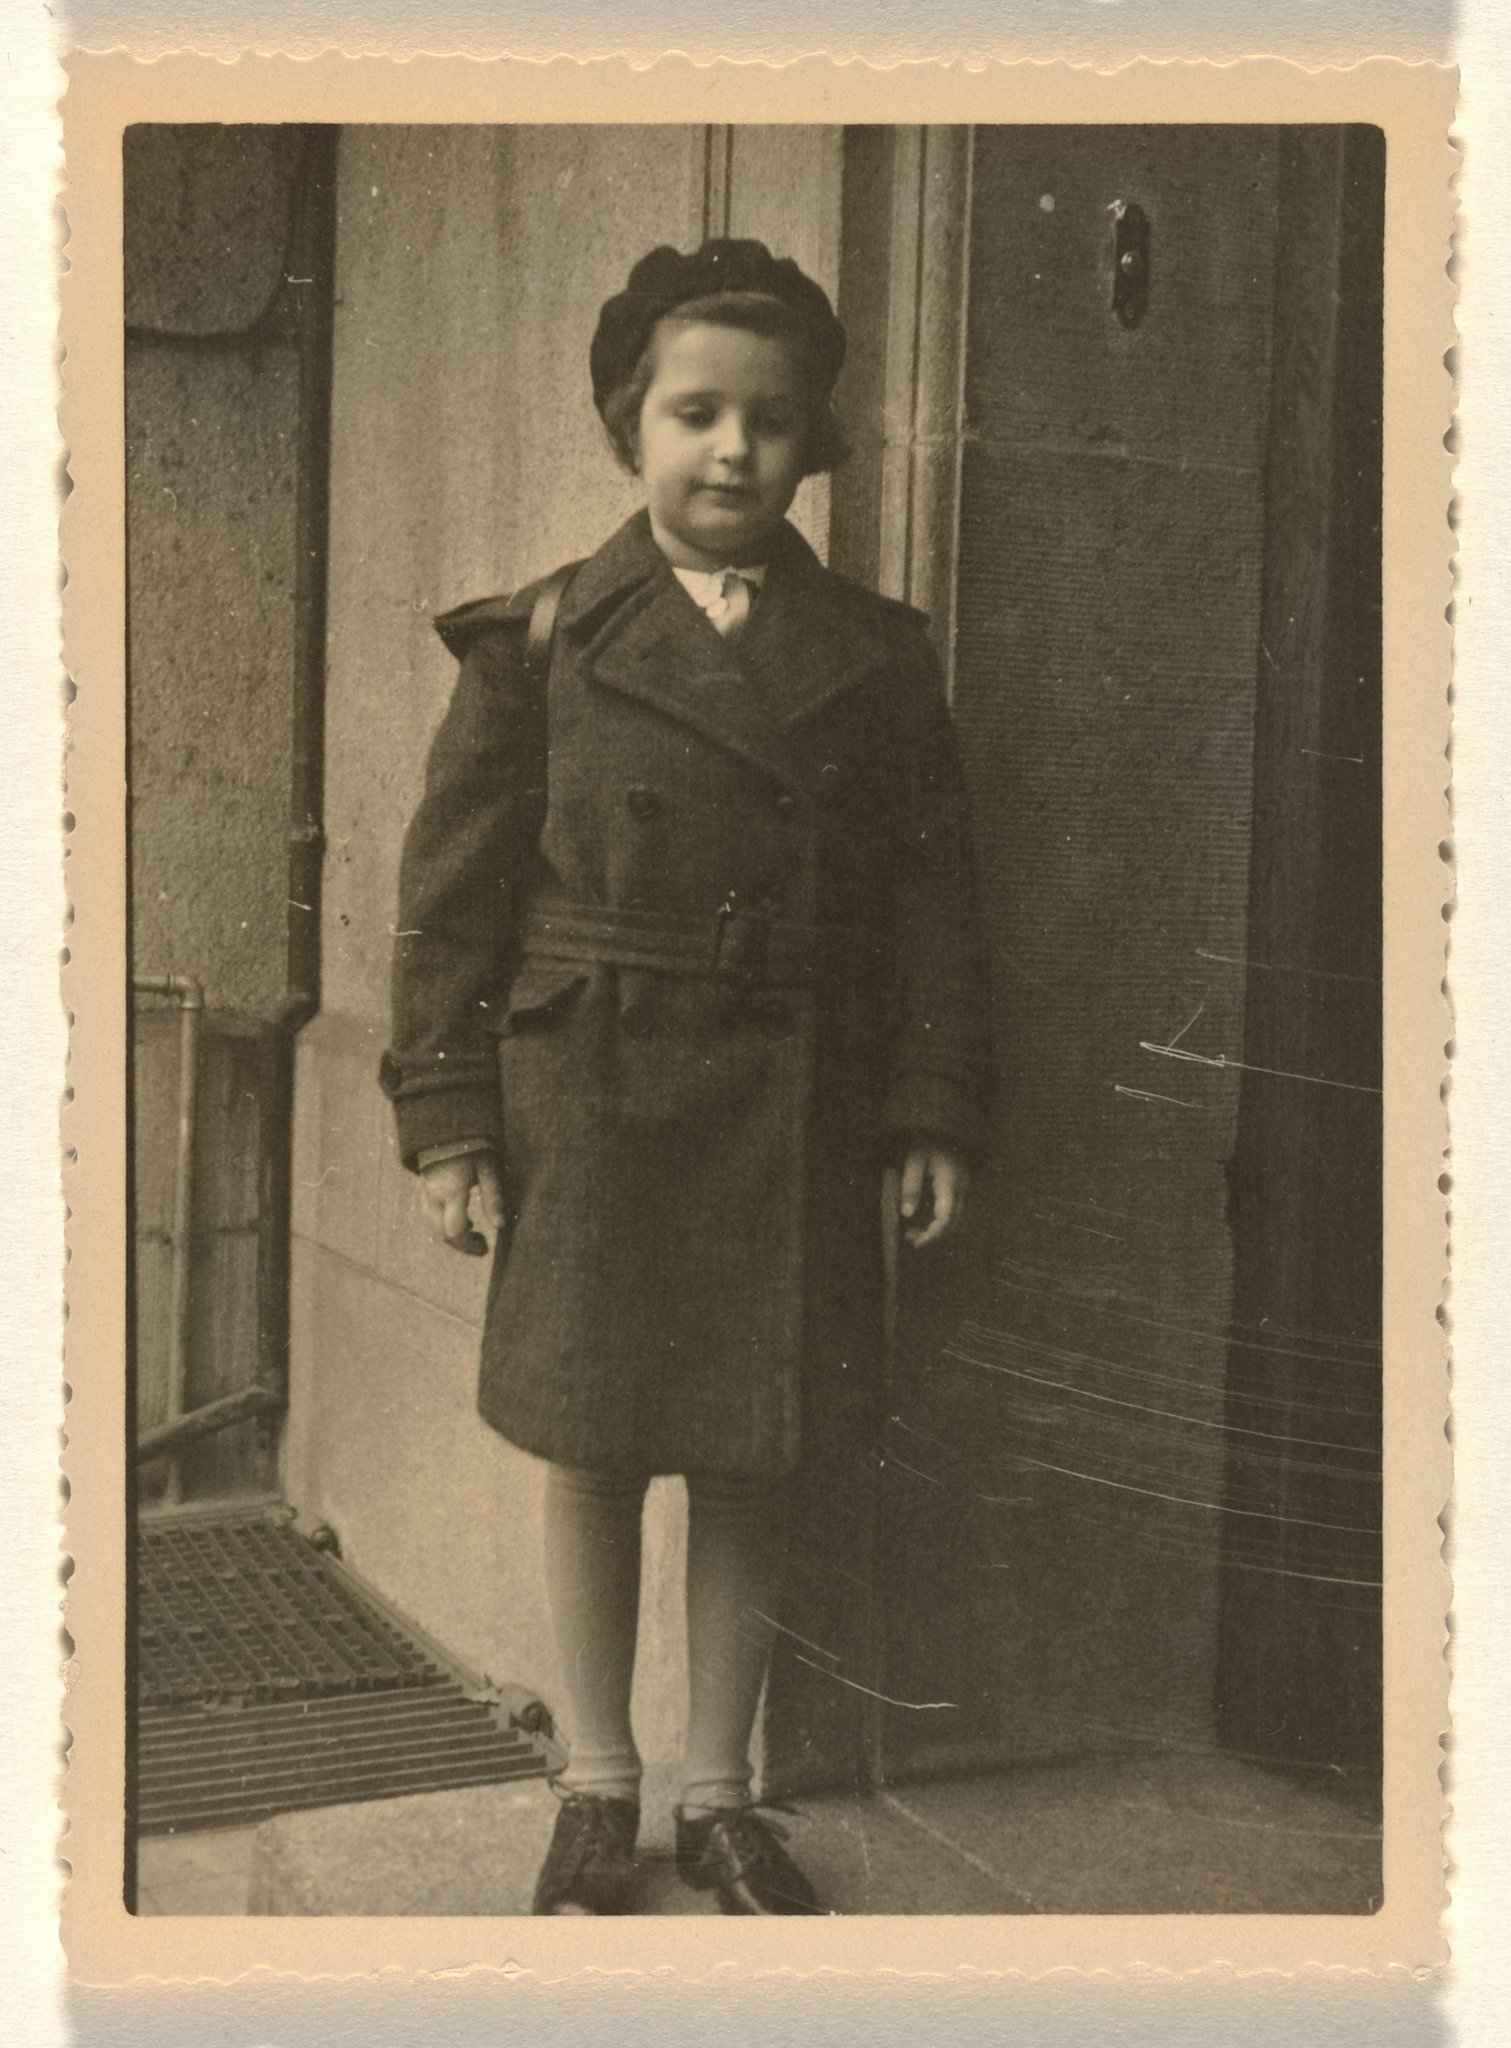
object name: photograph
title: Photographs from the Estate of Isabel Wachenheimer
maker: Anonymous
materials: photographic support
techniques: gelatin silver print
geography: stuttgart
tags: leiden, isabel wachenheimer-elon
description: In 1928 a daughter, Isabel, was born to Eugen and Else Wachenheimer. In 1934 they posed before the family home in Stuttgart on Isabel’s first day of school. The photograph at the lower right was taken almost ten years later (1943) in the Westerbork transit camp. Isabel had been rounded up in Amsterdam five months earlier. The family was first sent to Theresienstadt and then on to Auschwitz-Birkenau, where Eugen and Else were gassed. Isabel was condemned to forced labour.